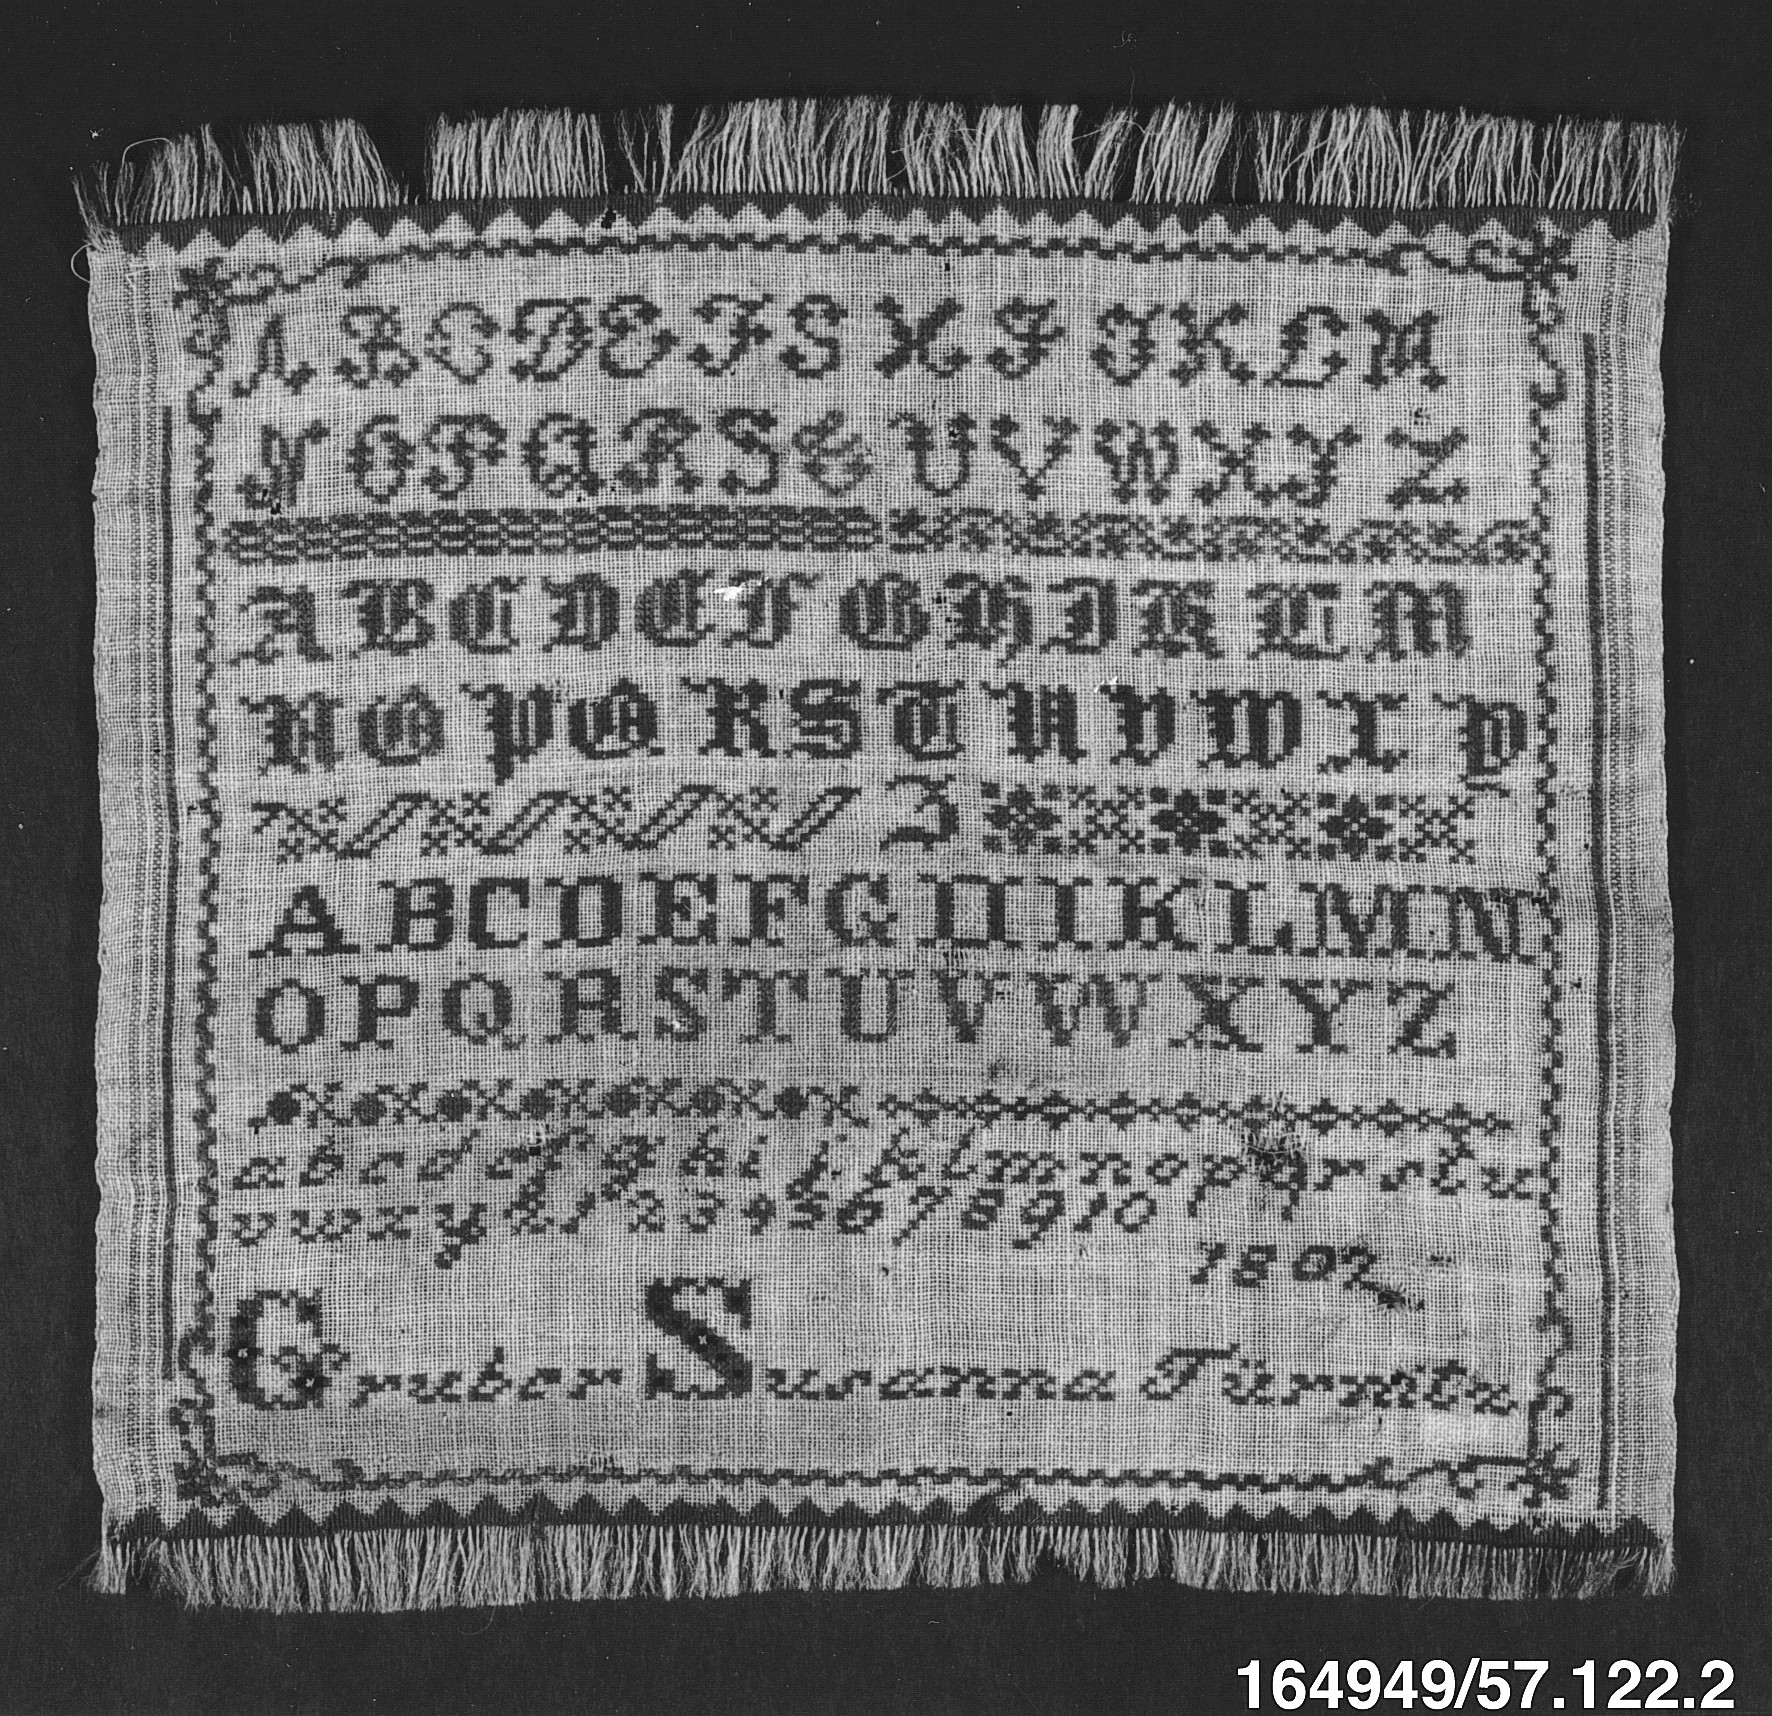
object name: sampler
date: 1849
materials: canvas, silk, wool